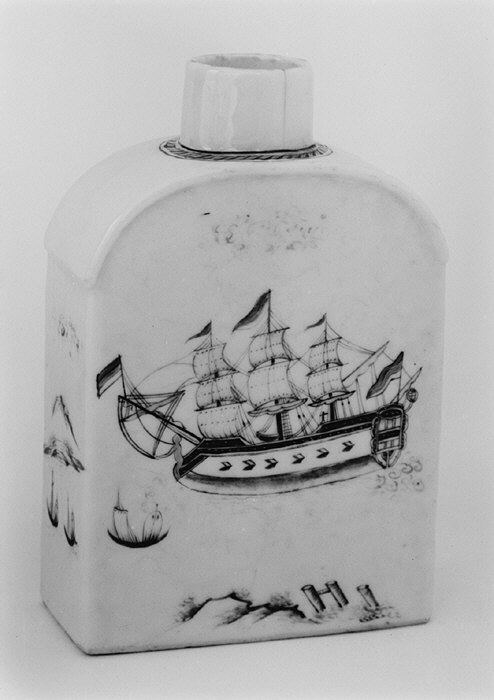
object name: tea caddy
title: Tea caddy (part of a set)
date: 1770-1780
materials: hard paste porcelain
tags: ships